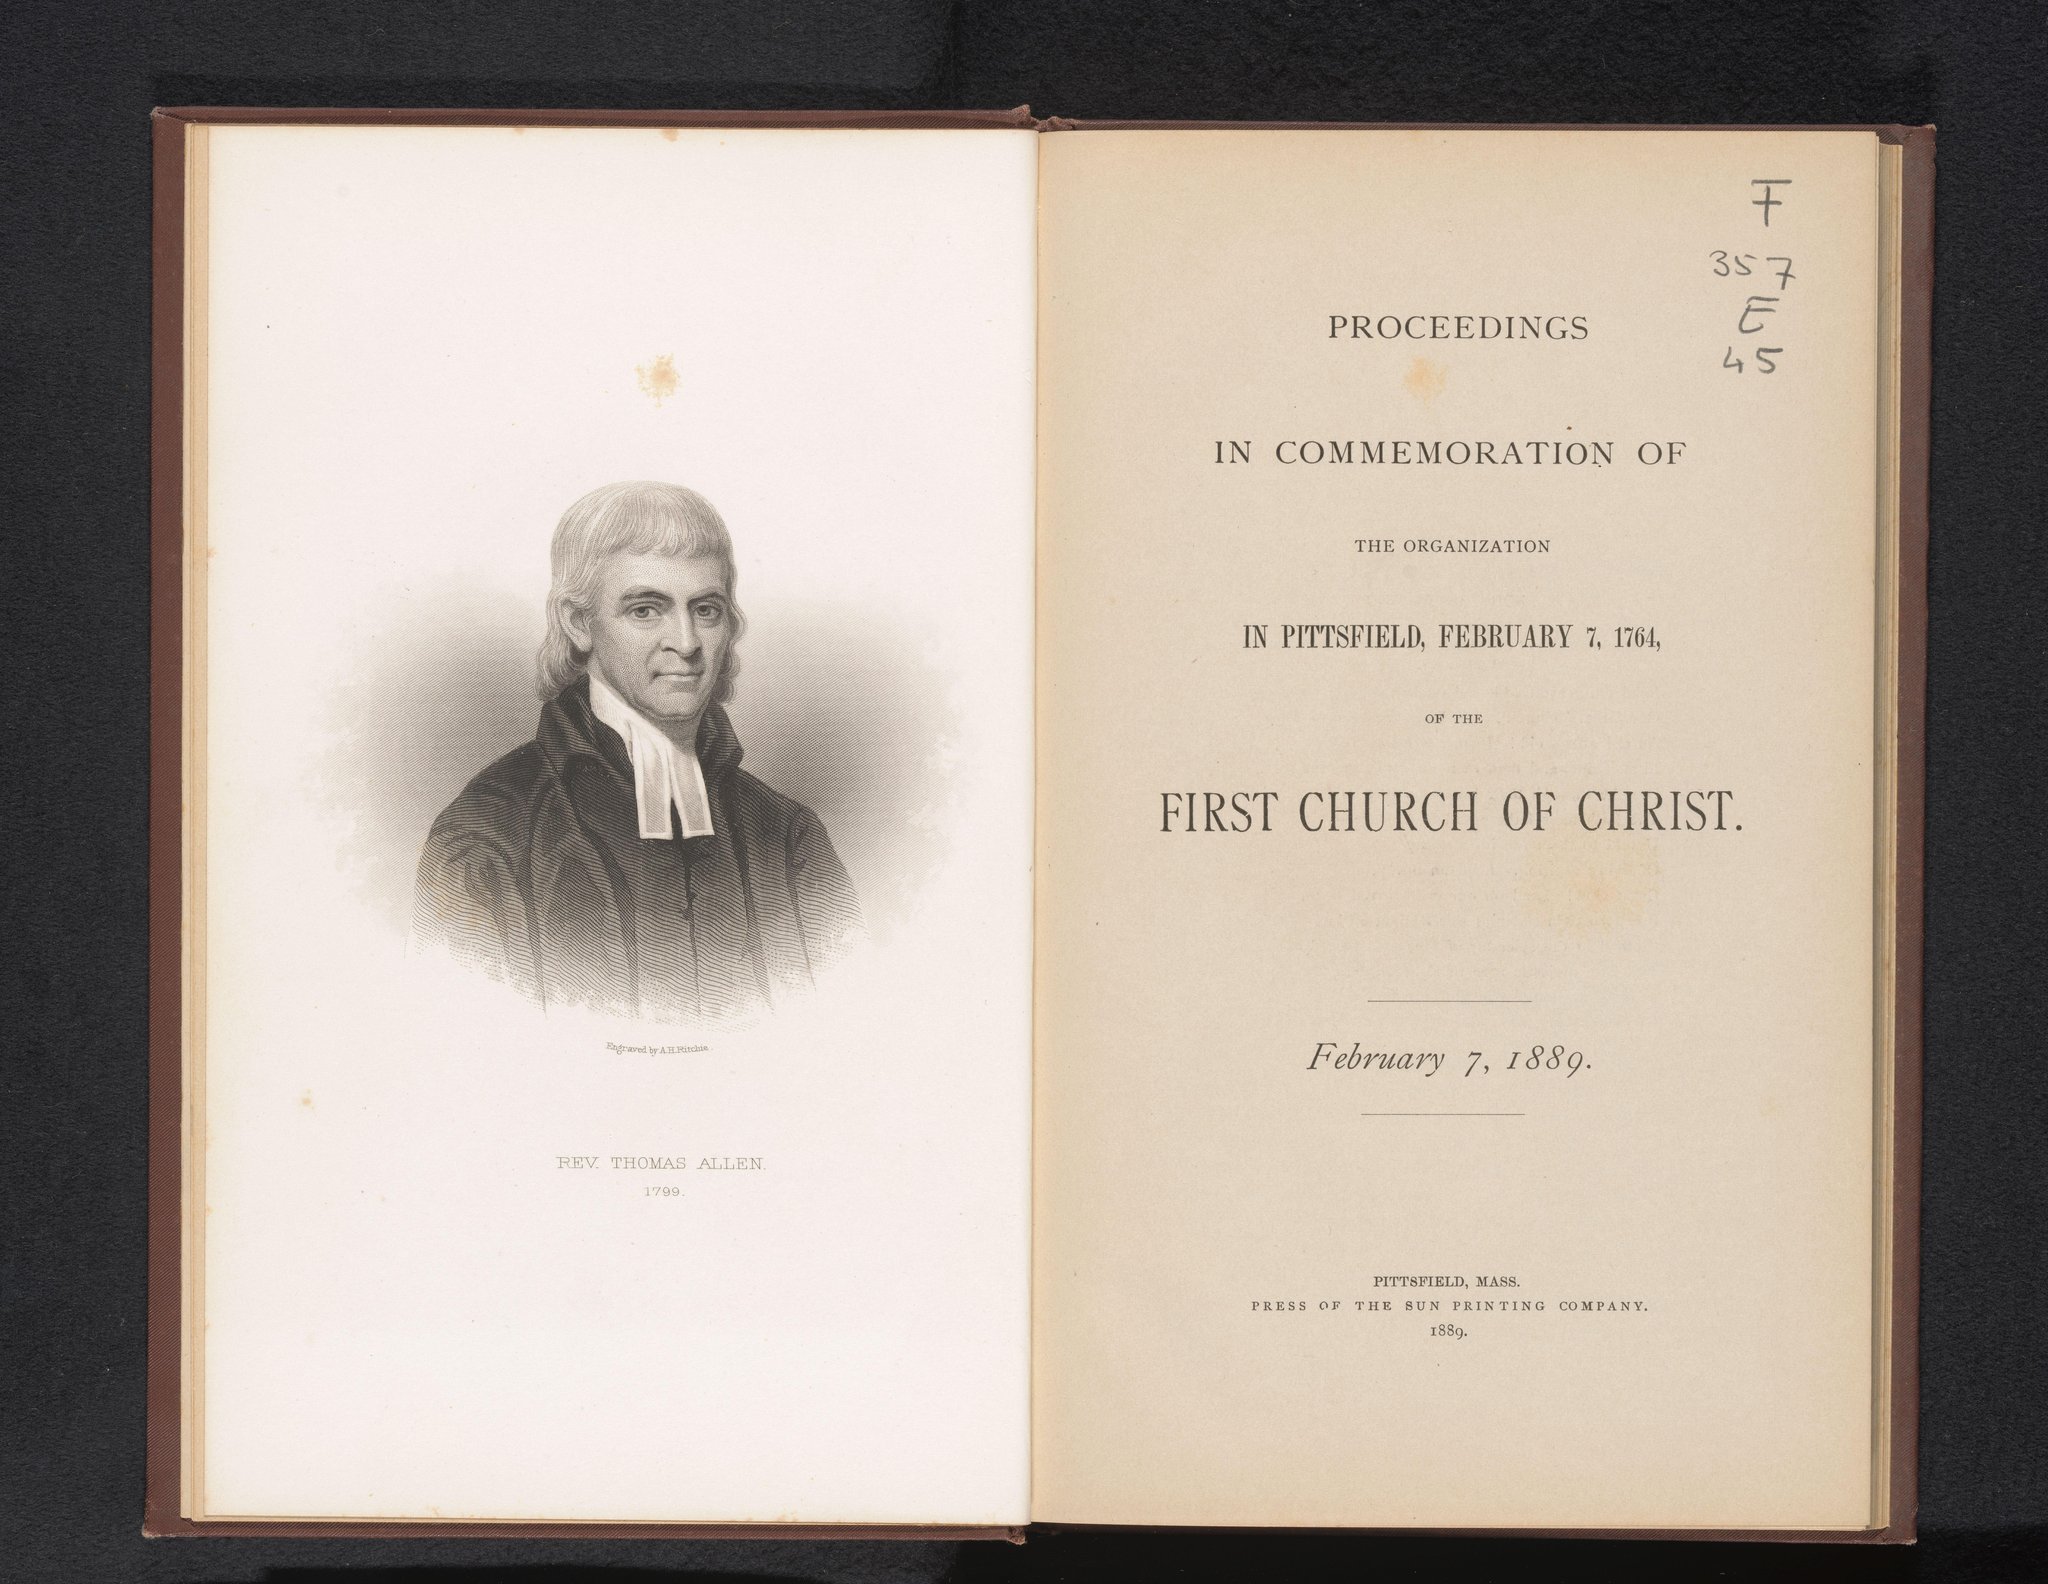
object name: photomechanical print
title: Interior of First Church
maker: Anonymous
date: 1889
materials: paper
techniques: photoaquatint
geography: pittsburgh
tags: interior of church